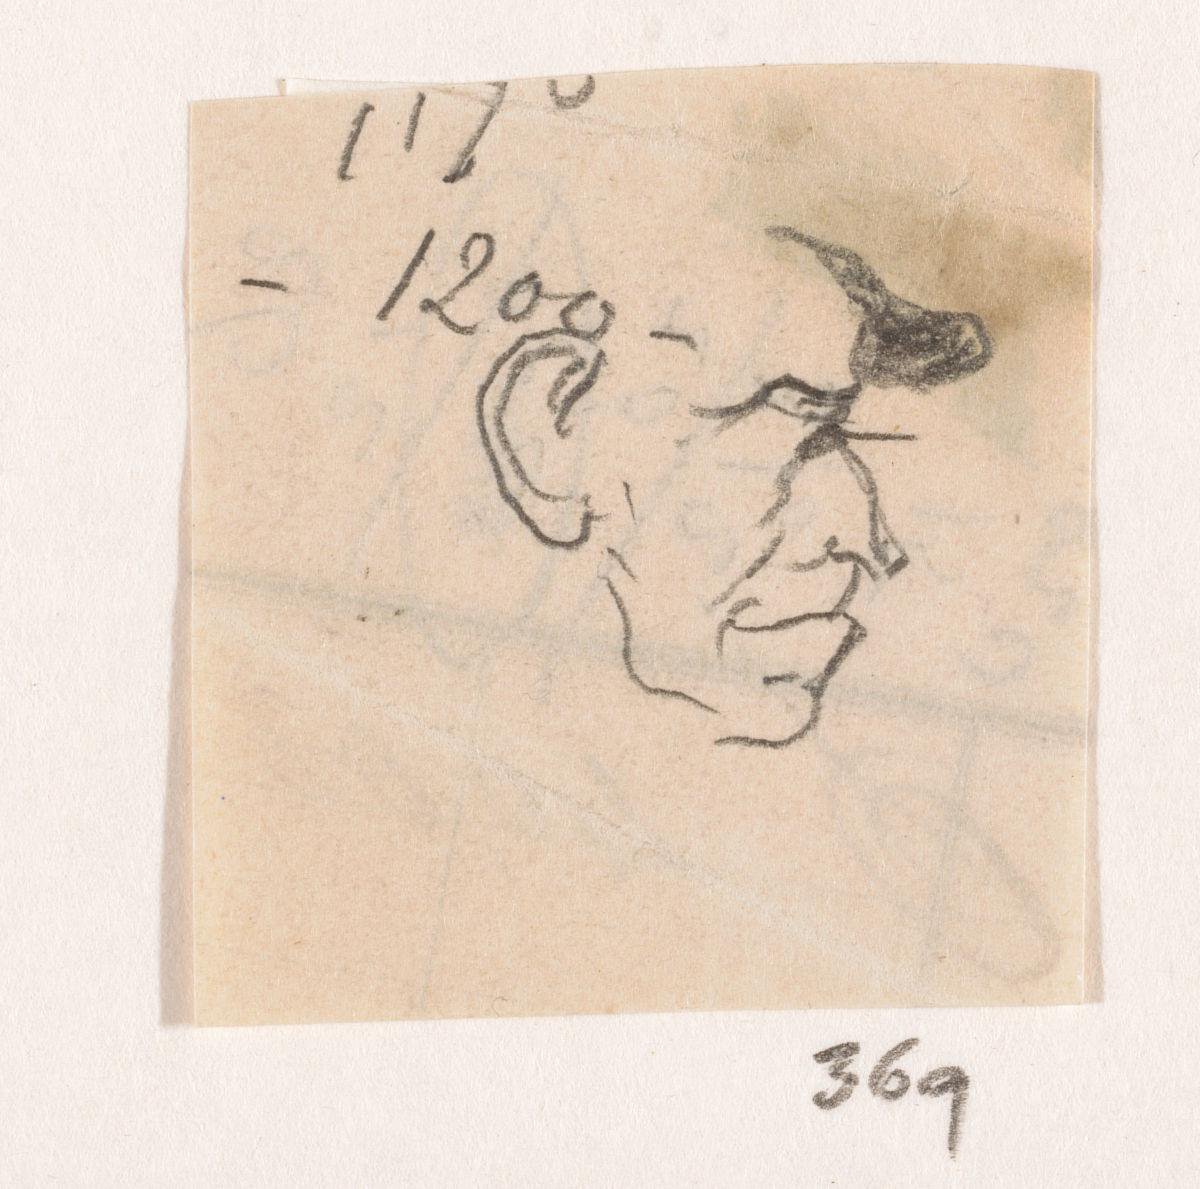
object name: drawing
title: Kop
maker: johannes tavenraat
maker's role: draughtsman, painter, print maker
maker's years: 1809-1881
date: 1840-1880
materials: paper, pencil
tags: caricatures (human types)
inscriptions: collector's mark: Lugt 2228